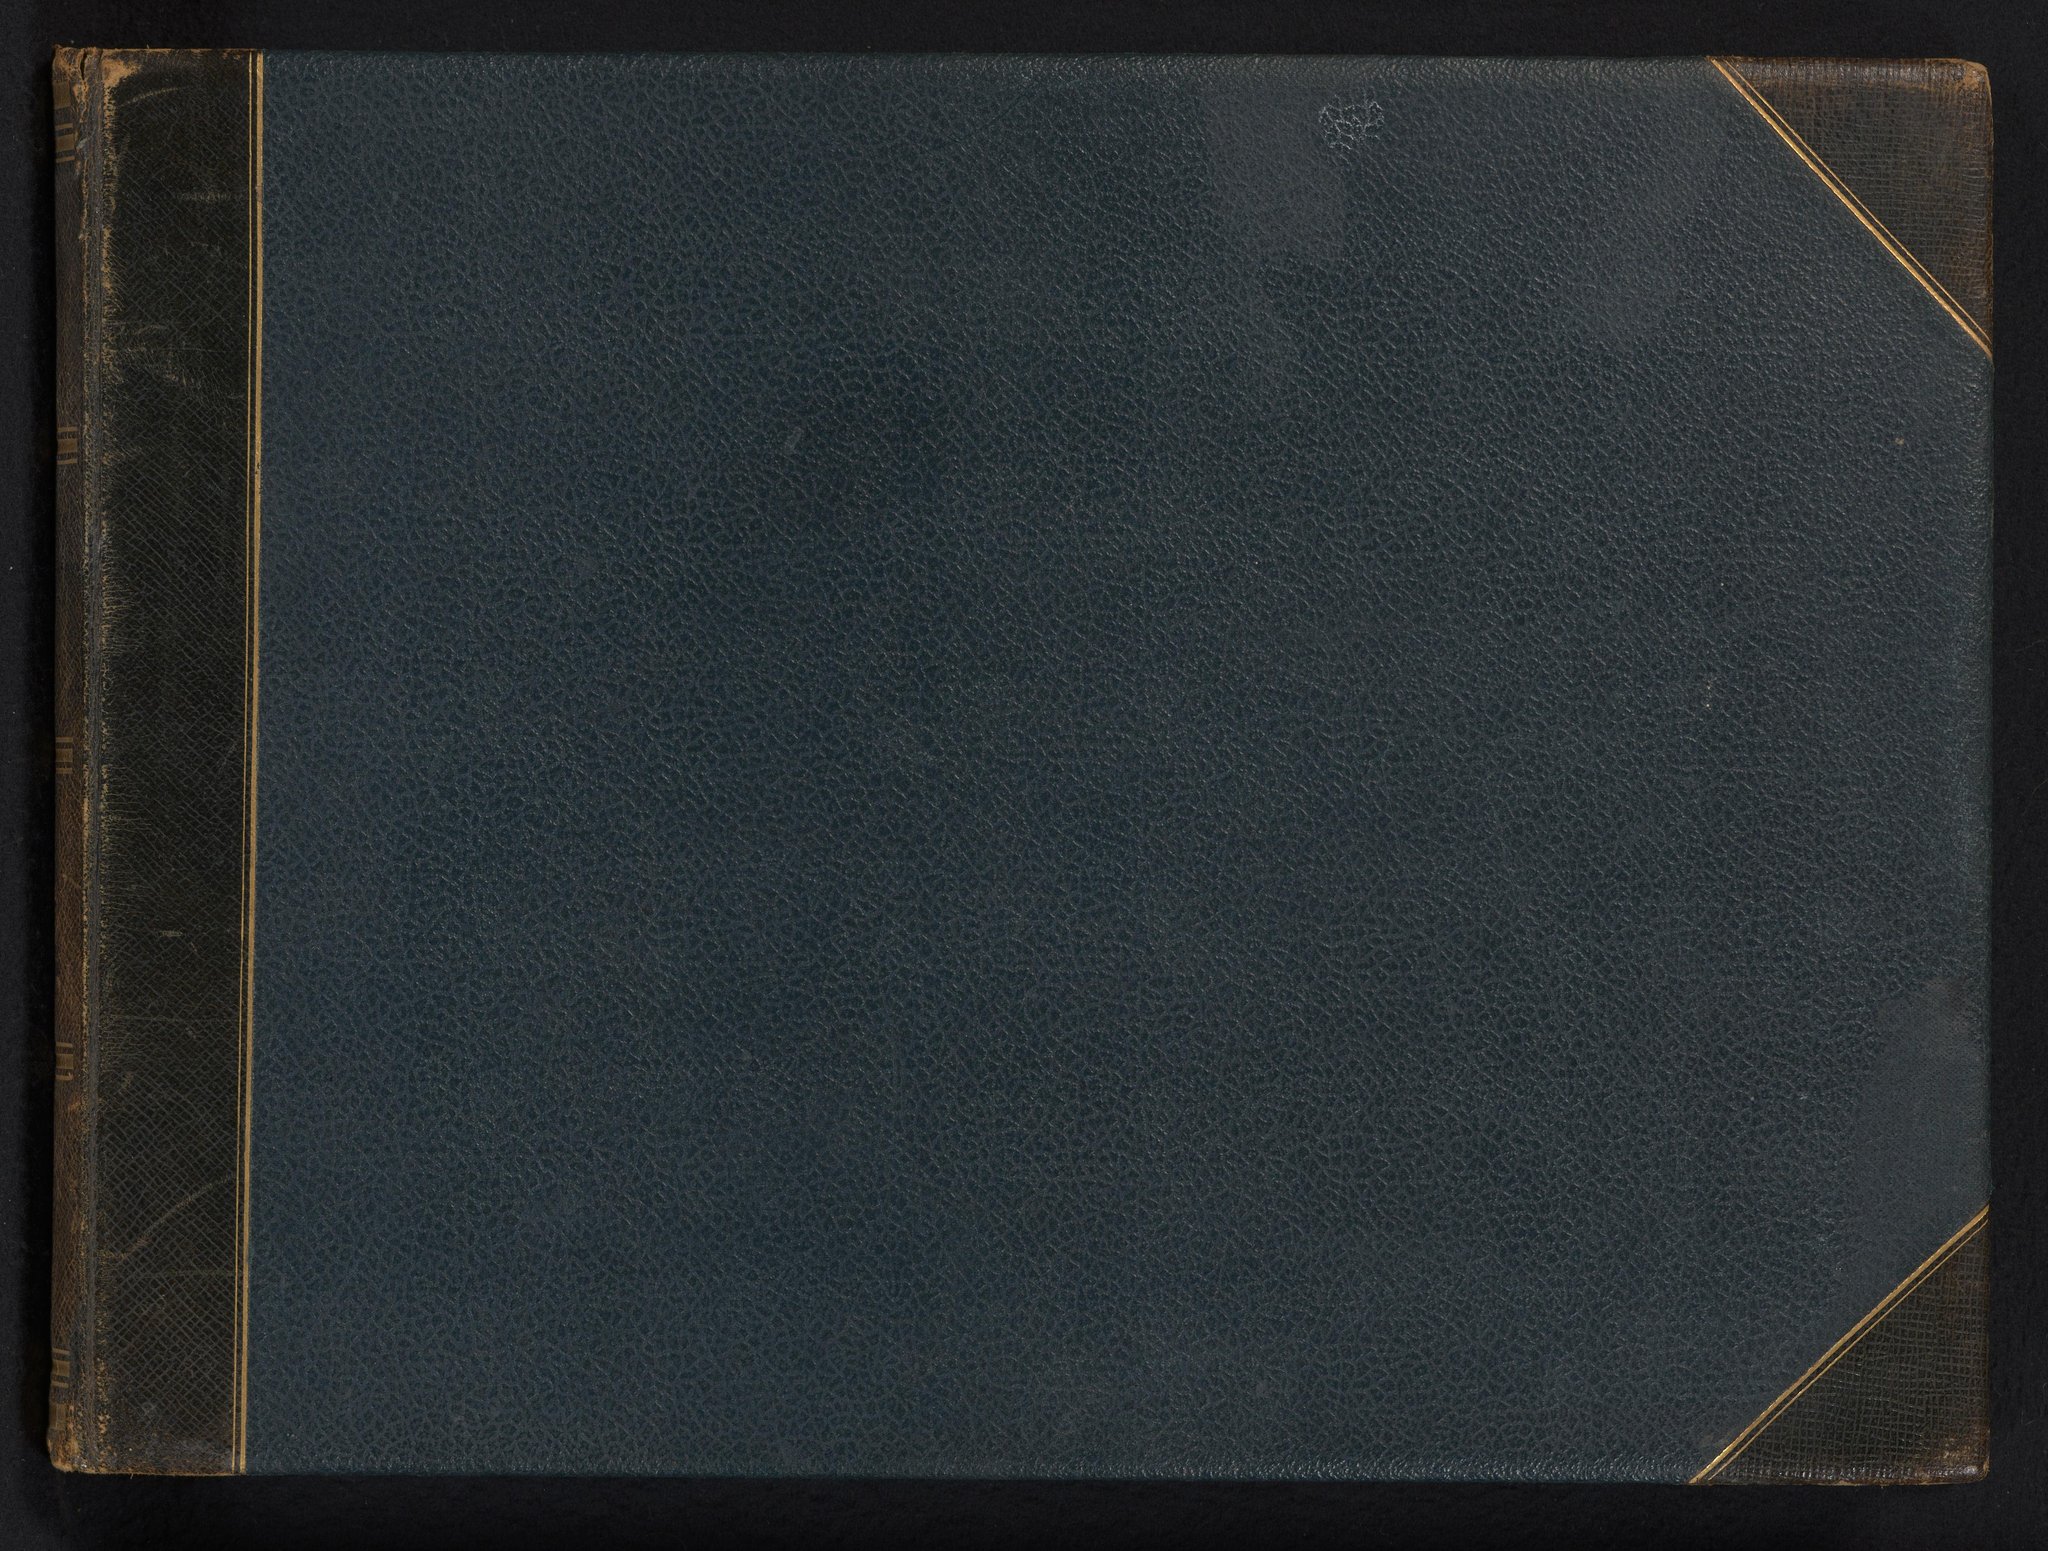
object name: scrapbook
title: Zeilschepen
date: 1880-1900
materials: cardboard, leather, paper, photographic support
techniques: albumen print, gelatin silver print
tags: sailing-ship, sailing-boat, landscapes with waters, waterscapes, seascapes (in the temperate zone), (high) hill, civic architecture; edifices; dwellings, coast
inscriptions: annotation: ‘[...] 562/ foto's Adamson Rothesay’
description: Pagina's 14, 16, 18, 20, 22, 24, 26, 28, 30, 32, 34, 36, 40, 42, 44, 46, 48, 50, 52, 54, 56, 58 en 60 bevatten geen foto's.